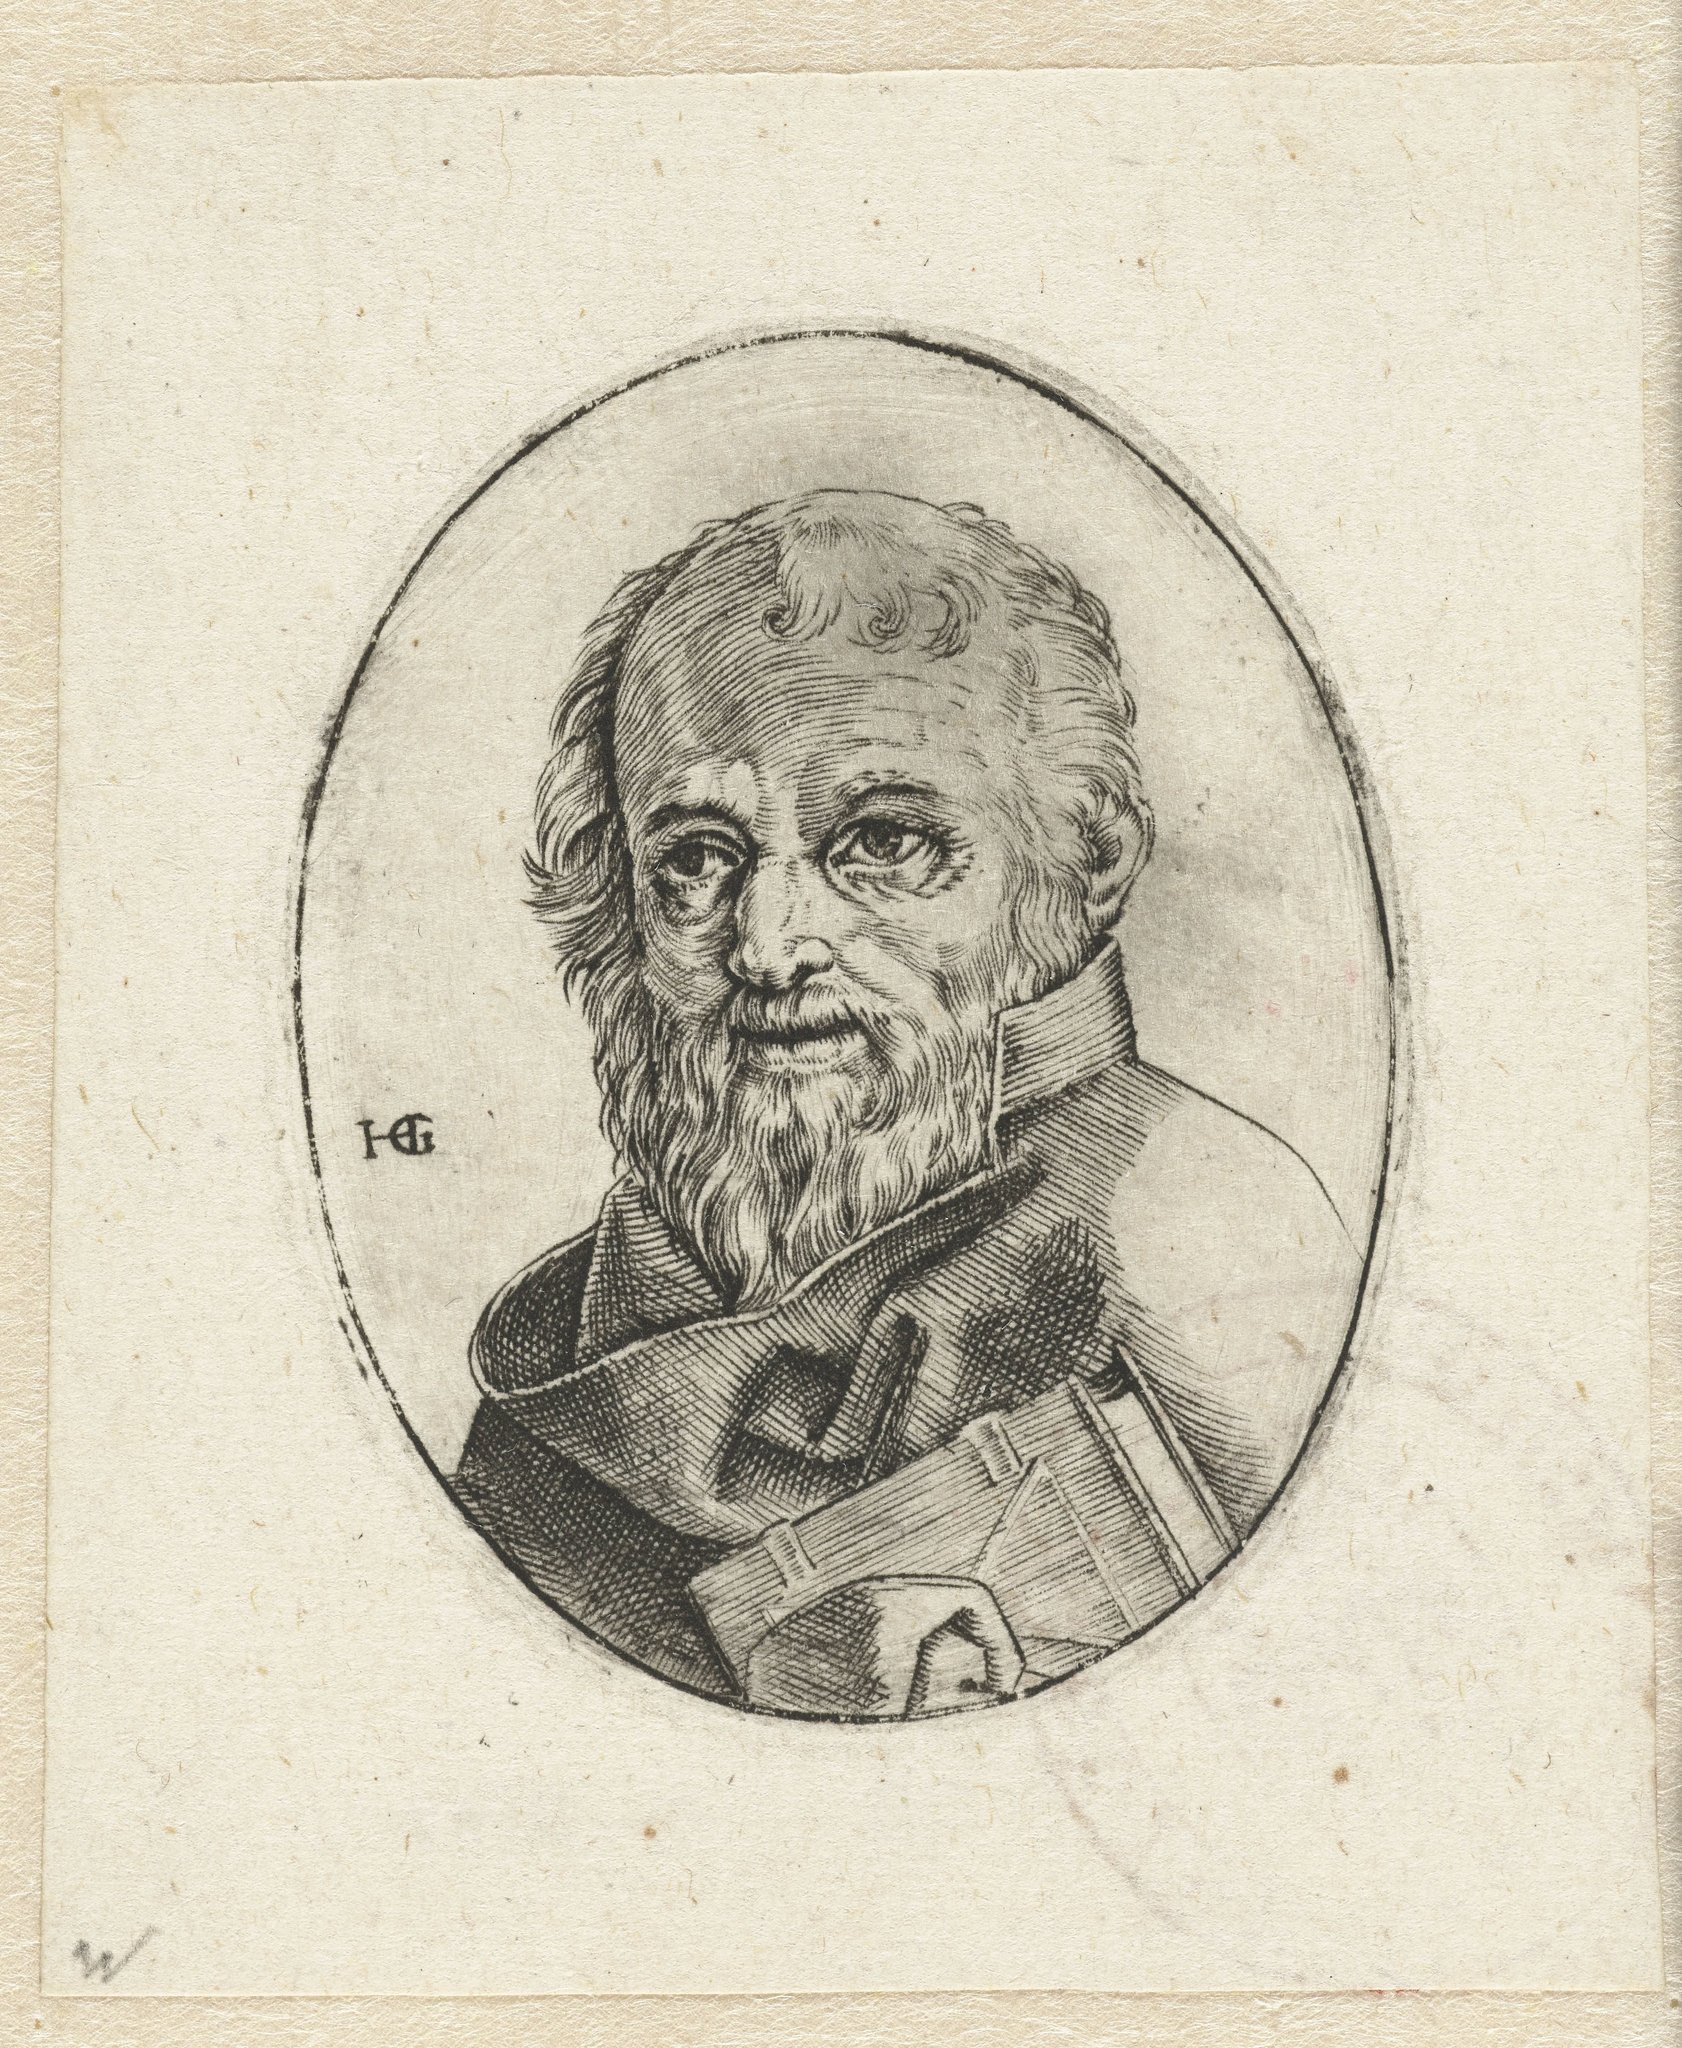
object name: print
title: Portret van een oude man met een boek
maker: hendrick goltzius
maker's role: draughtsman, painter, print maker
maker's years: 1558-1617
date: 1587-1591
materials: paper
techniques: engraving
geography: haarlem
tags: the apostle and martyr matthias; possible attributes: axe, book, cross, halberd, scroll, sword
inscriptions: collector's mark: Lugt 240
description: Ovaal busteportret van een oude man met een boek tegen de borst geklemd.